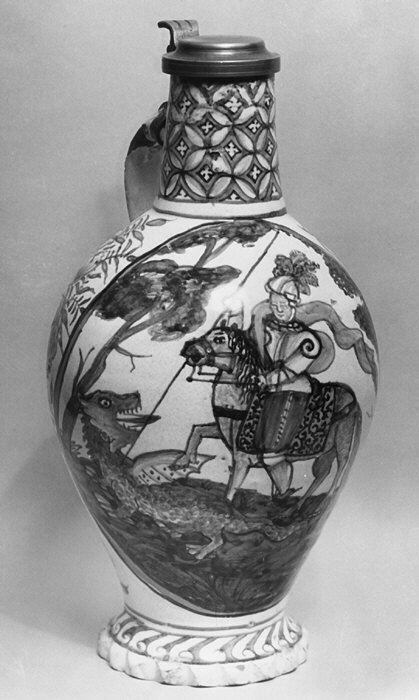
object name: jug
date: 1640-1650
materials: earthenware, pewter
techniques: glazing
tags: men,dragons,horses,saint george